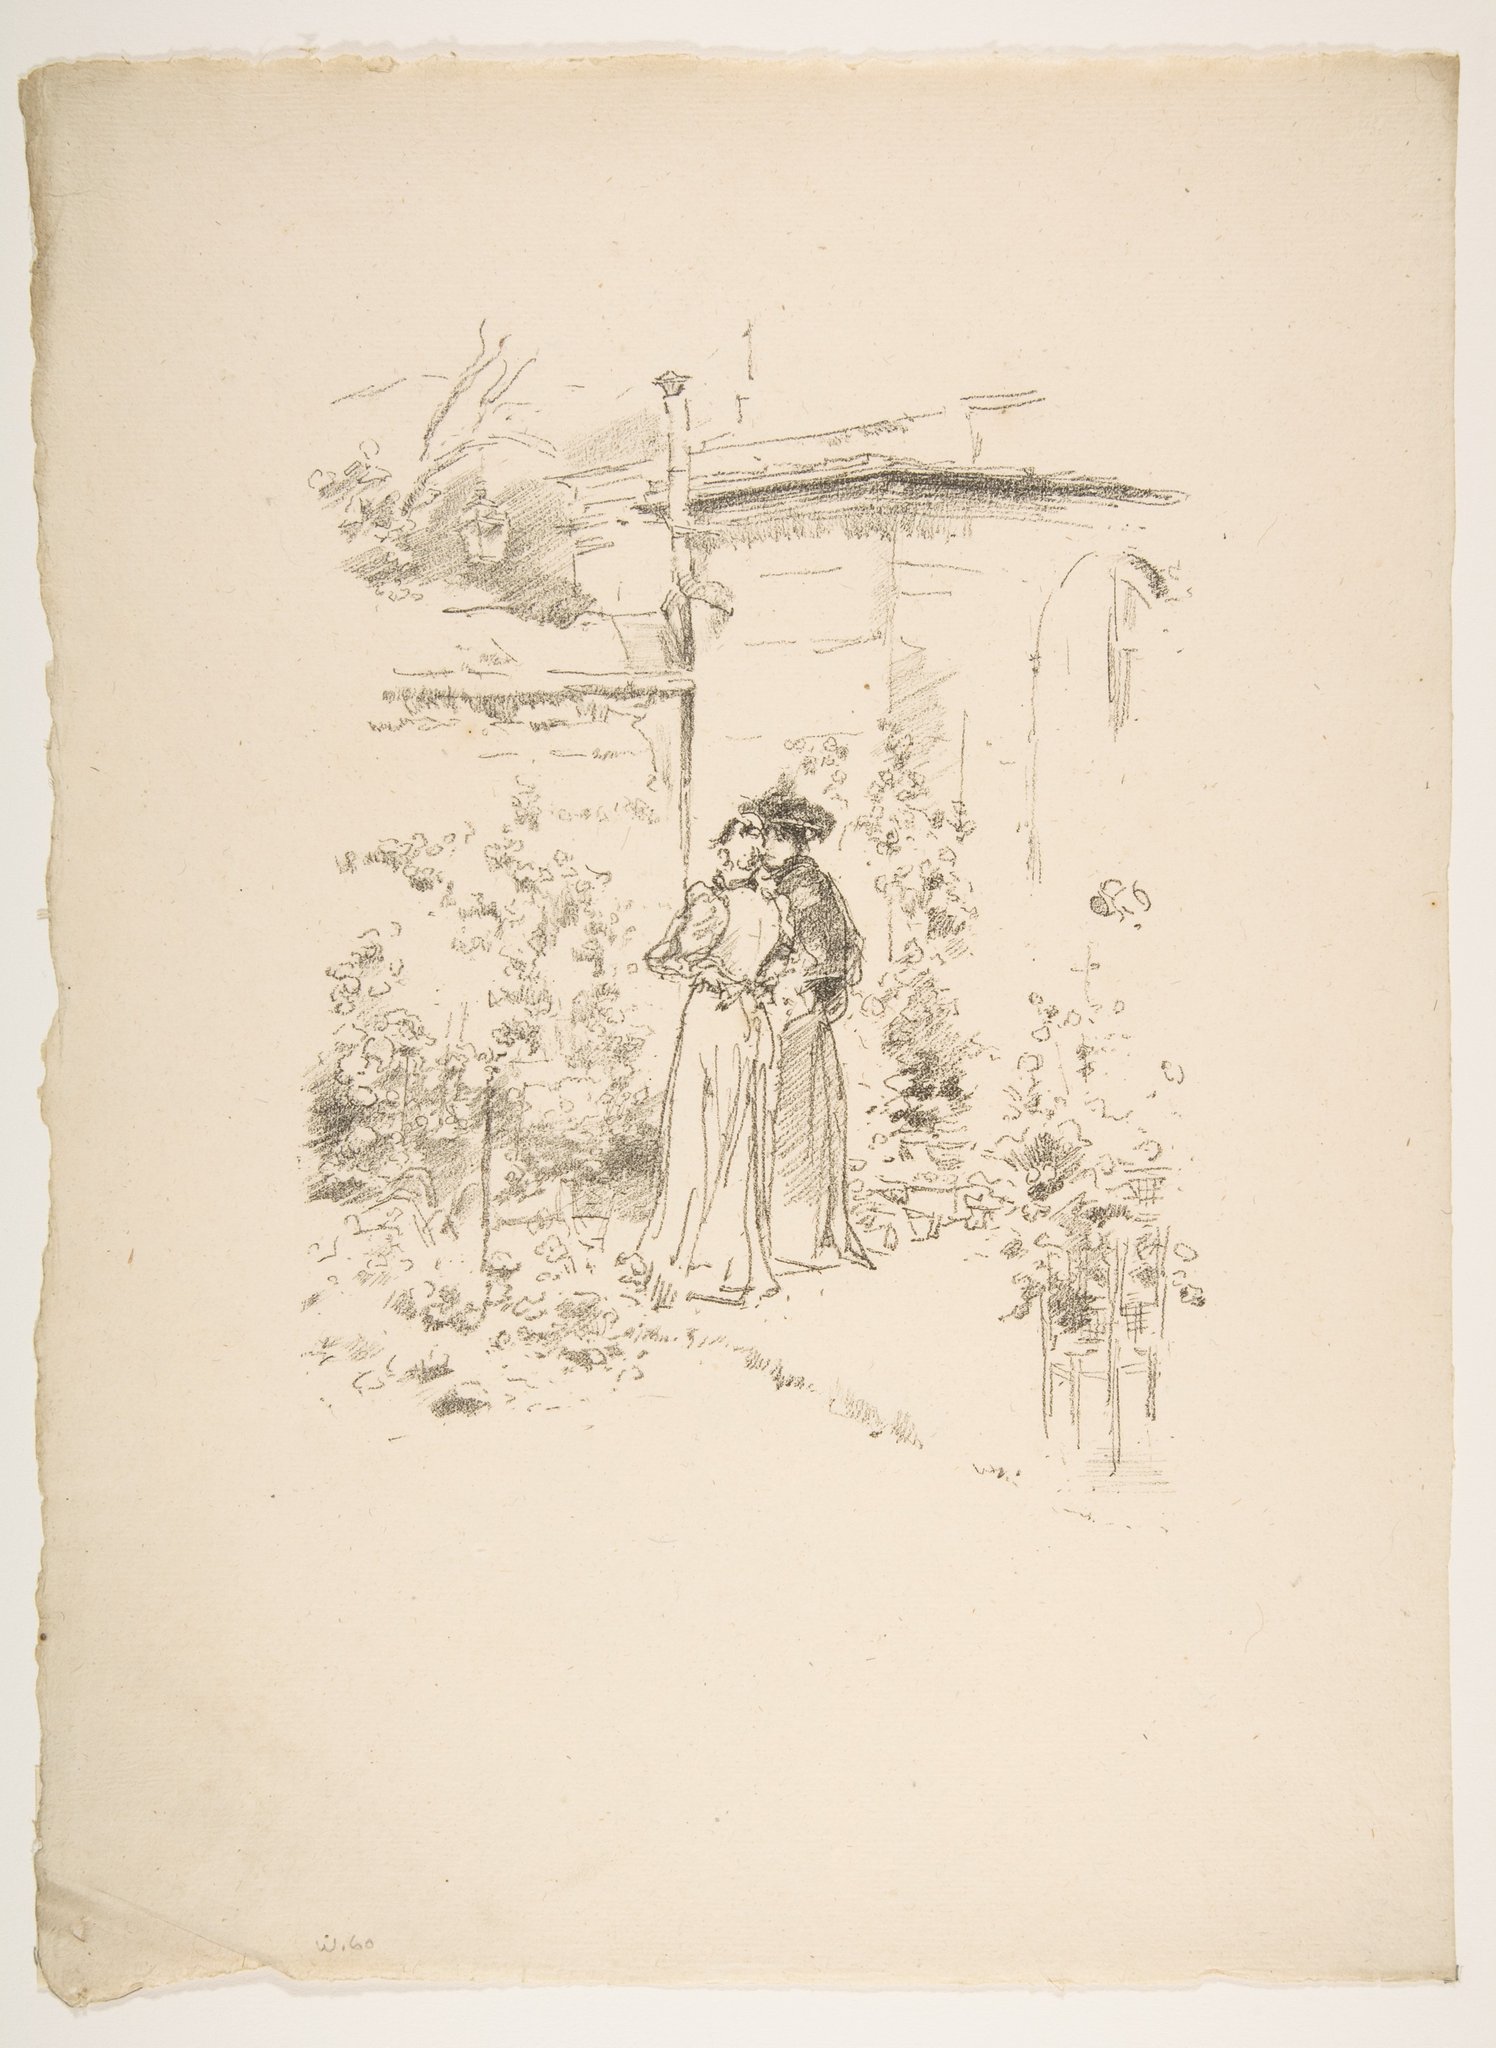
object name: print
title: Confidences in the Garden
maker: james mcneill whistler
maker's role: artist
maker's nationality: american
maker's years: 1834-1903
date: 1894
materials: ink, paper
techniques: printing, lithography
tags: human figures,gardens